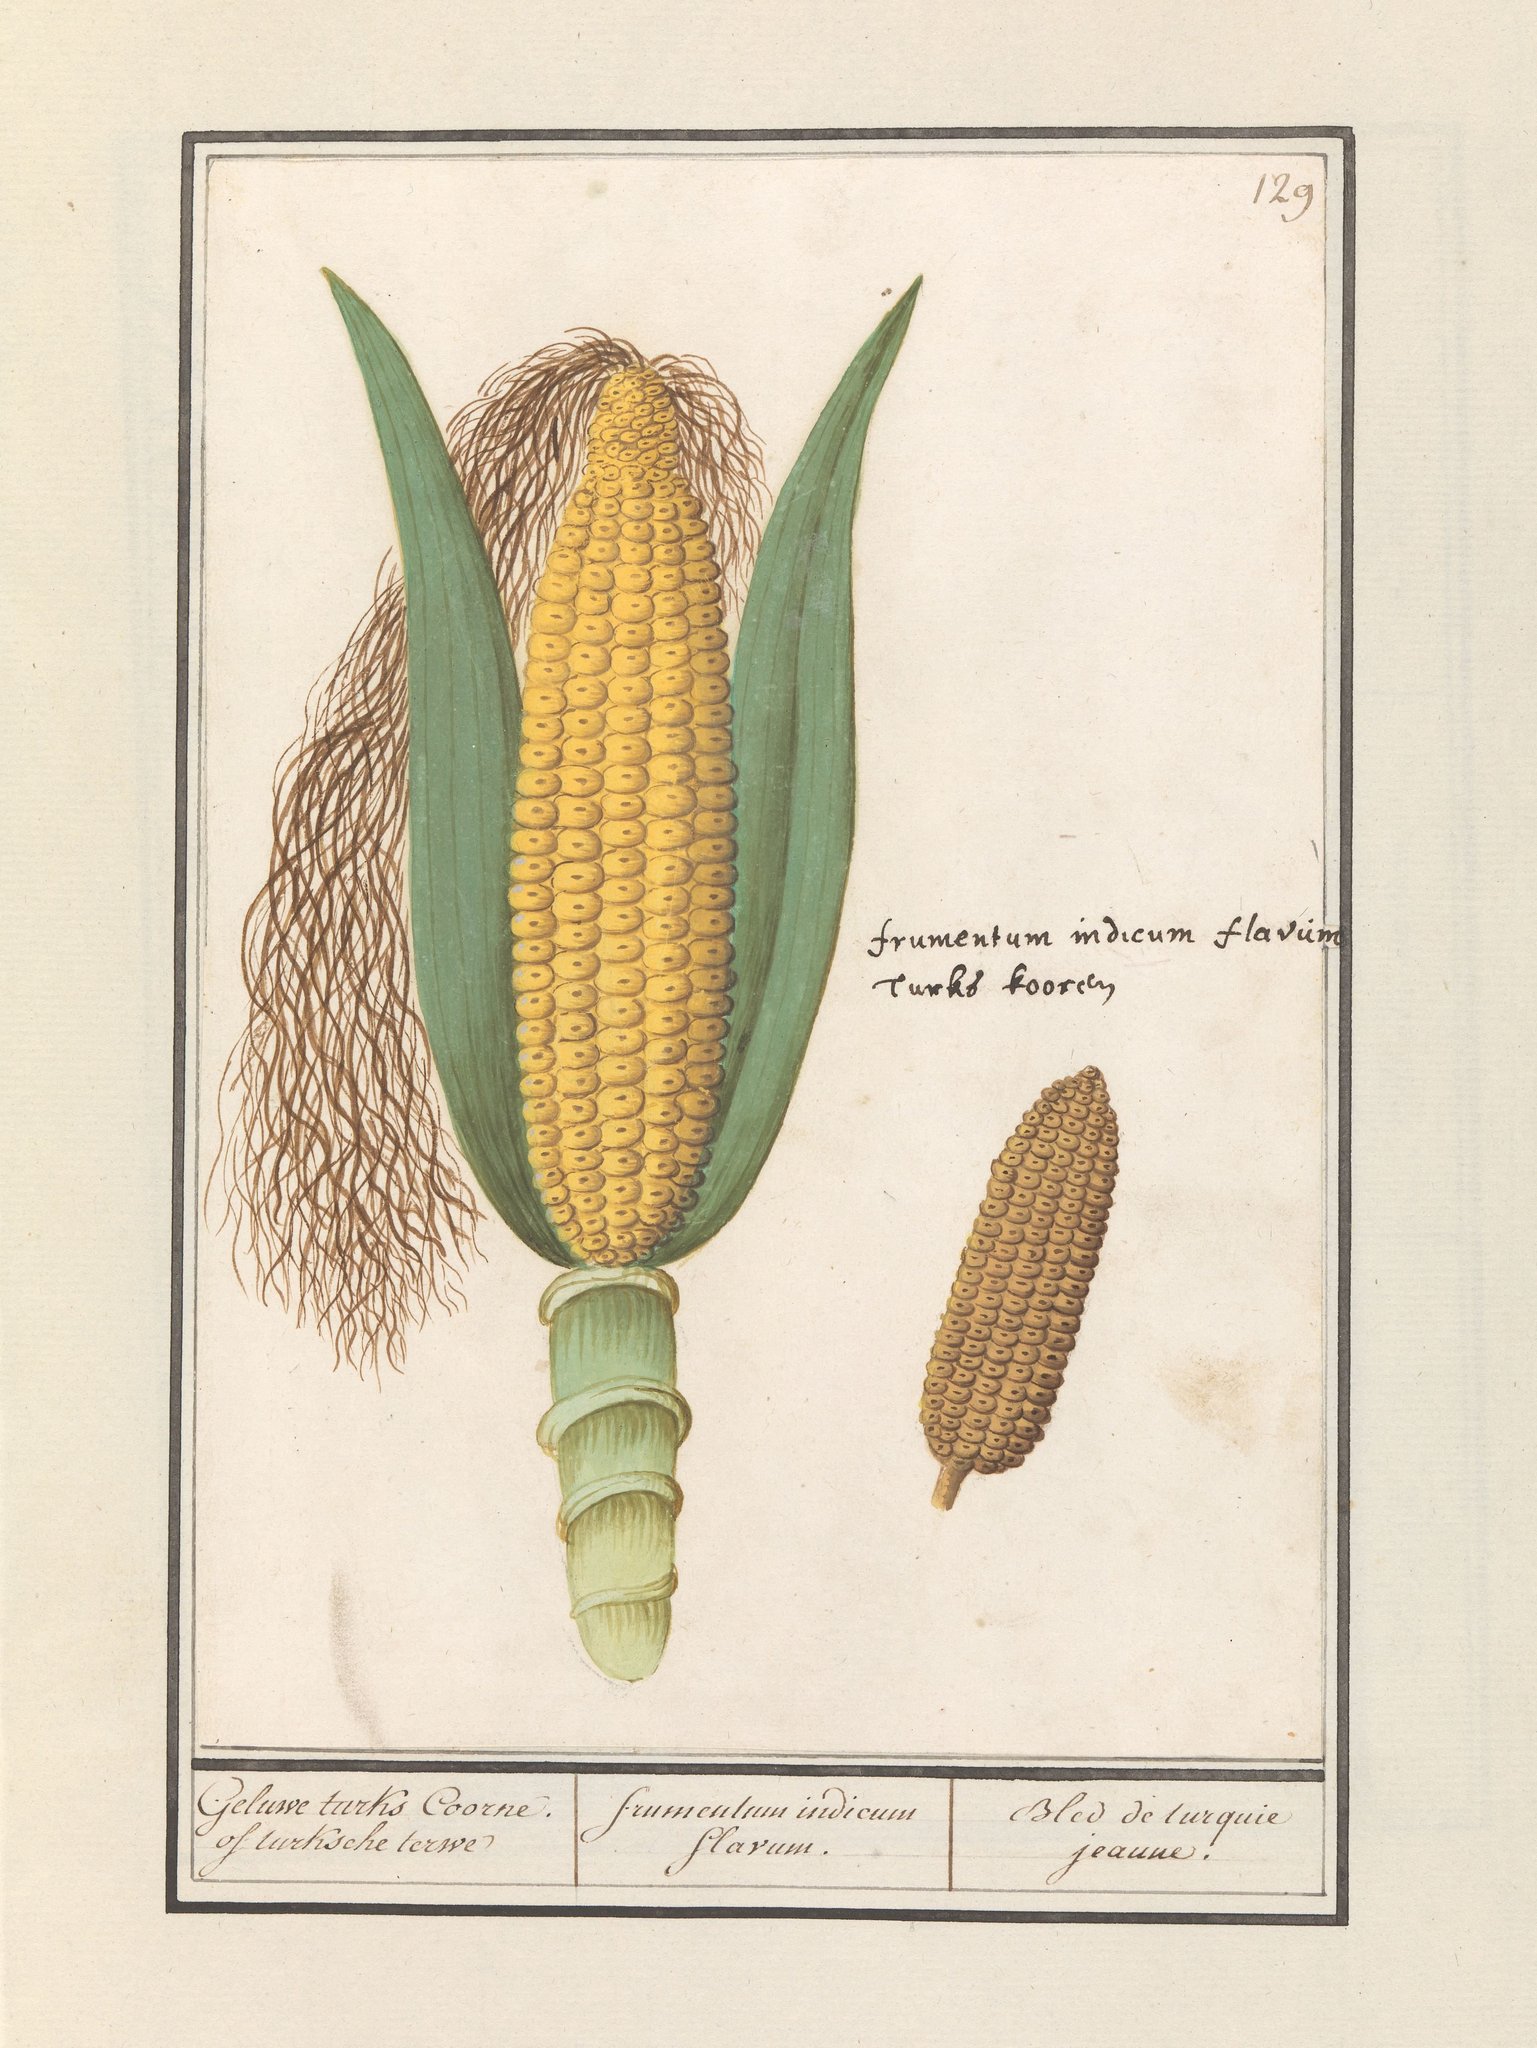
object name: drawing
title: Geluwe turks Coorne. of turksche terwe / frumentum indicum flavum. / Bled de turquie jeaune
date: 1596-1610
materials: paint, ink, paper, watercolor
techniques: brush, pen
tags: ear of corn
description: Mais. Rechtsboven genummerd: 129. Rechts de naam in Latijn en Nederlands. Onderdeel van het tweede album met tekeningen van bloemen en planten. Negende van twaalf albums met tekeningen van dieren, vogels en planten bekend rond 1600, gemaakt in opdracht van keizer Rudolf II. Met toelichting in Nederlands, Latijn en Frans.